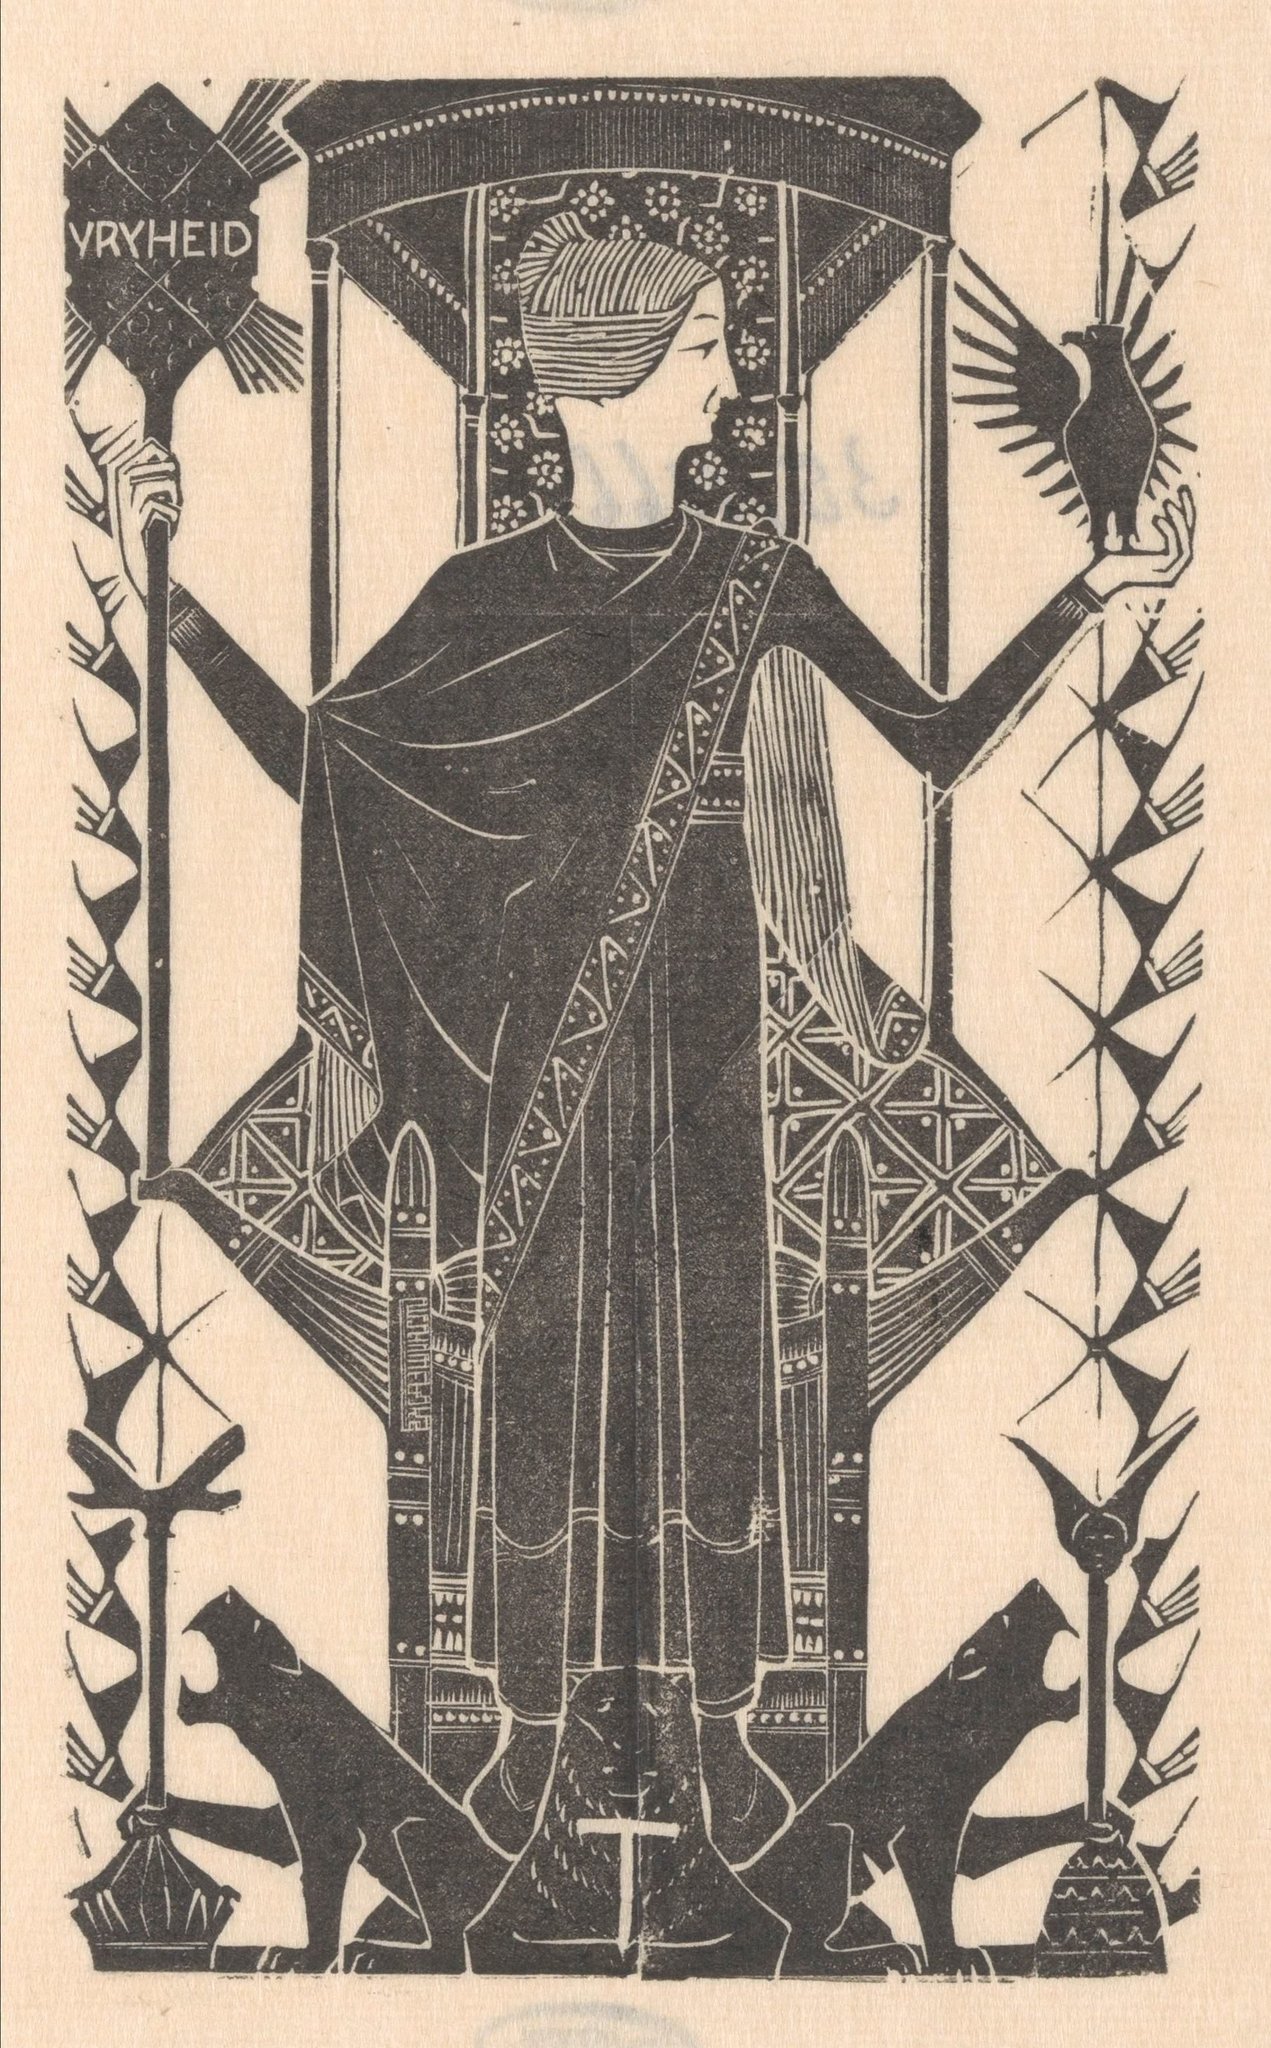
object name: print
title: Louise Michel onder baldakijn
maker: mathieu lauweriks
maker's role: designer, draughtsman, print maker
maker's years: 1864-1932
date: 1896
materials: paper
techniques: woodcut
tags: freedom, liberty; 'libertà' (ripa)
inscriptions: collector's mark: Lugt 2228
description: Louise Michel staat onder een baldakijn. In haar linkerhand houdt zij een vogel; in haar rechterhand een bord met het woord 'vrijheid'.